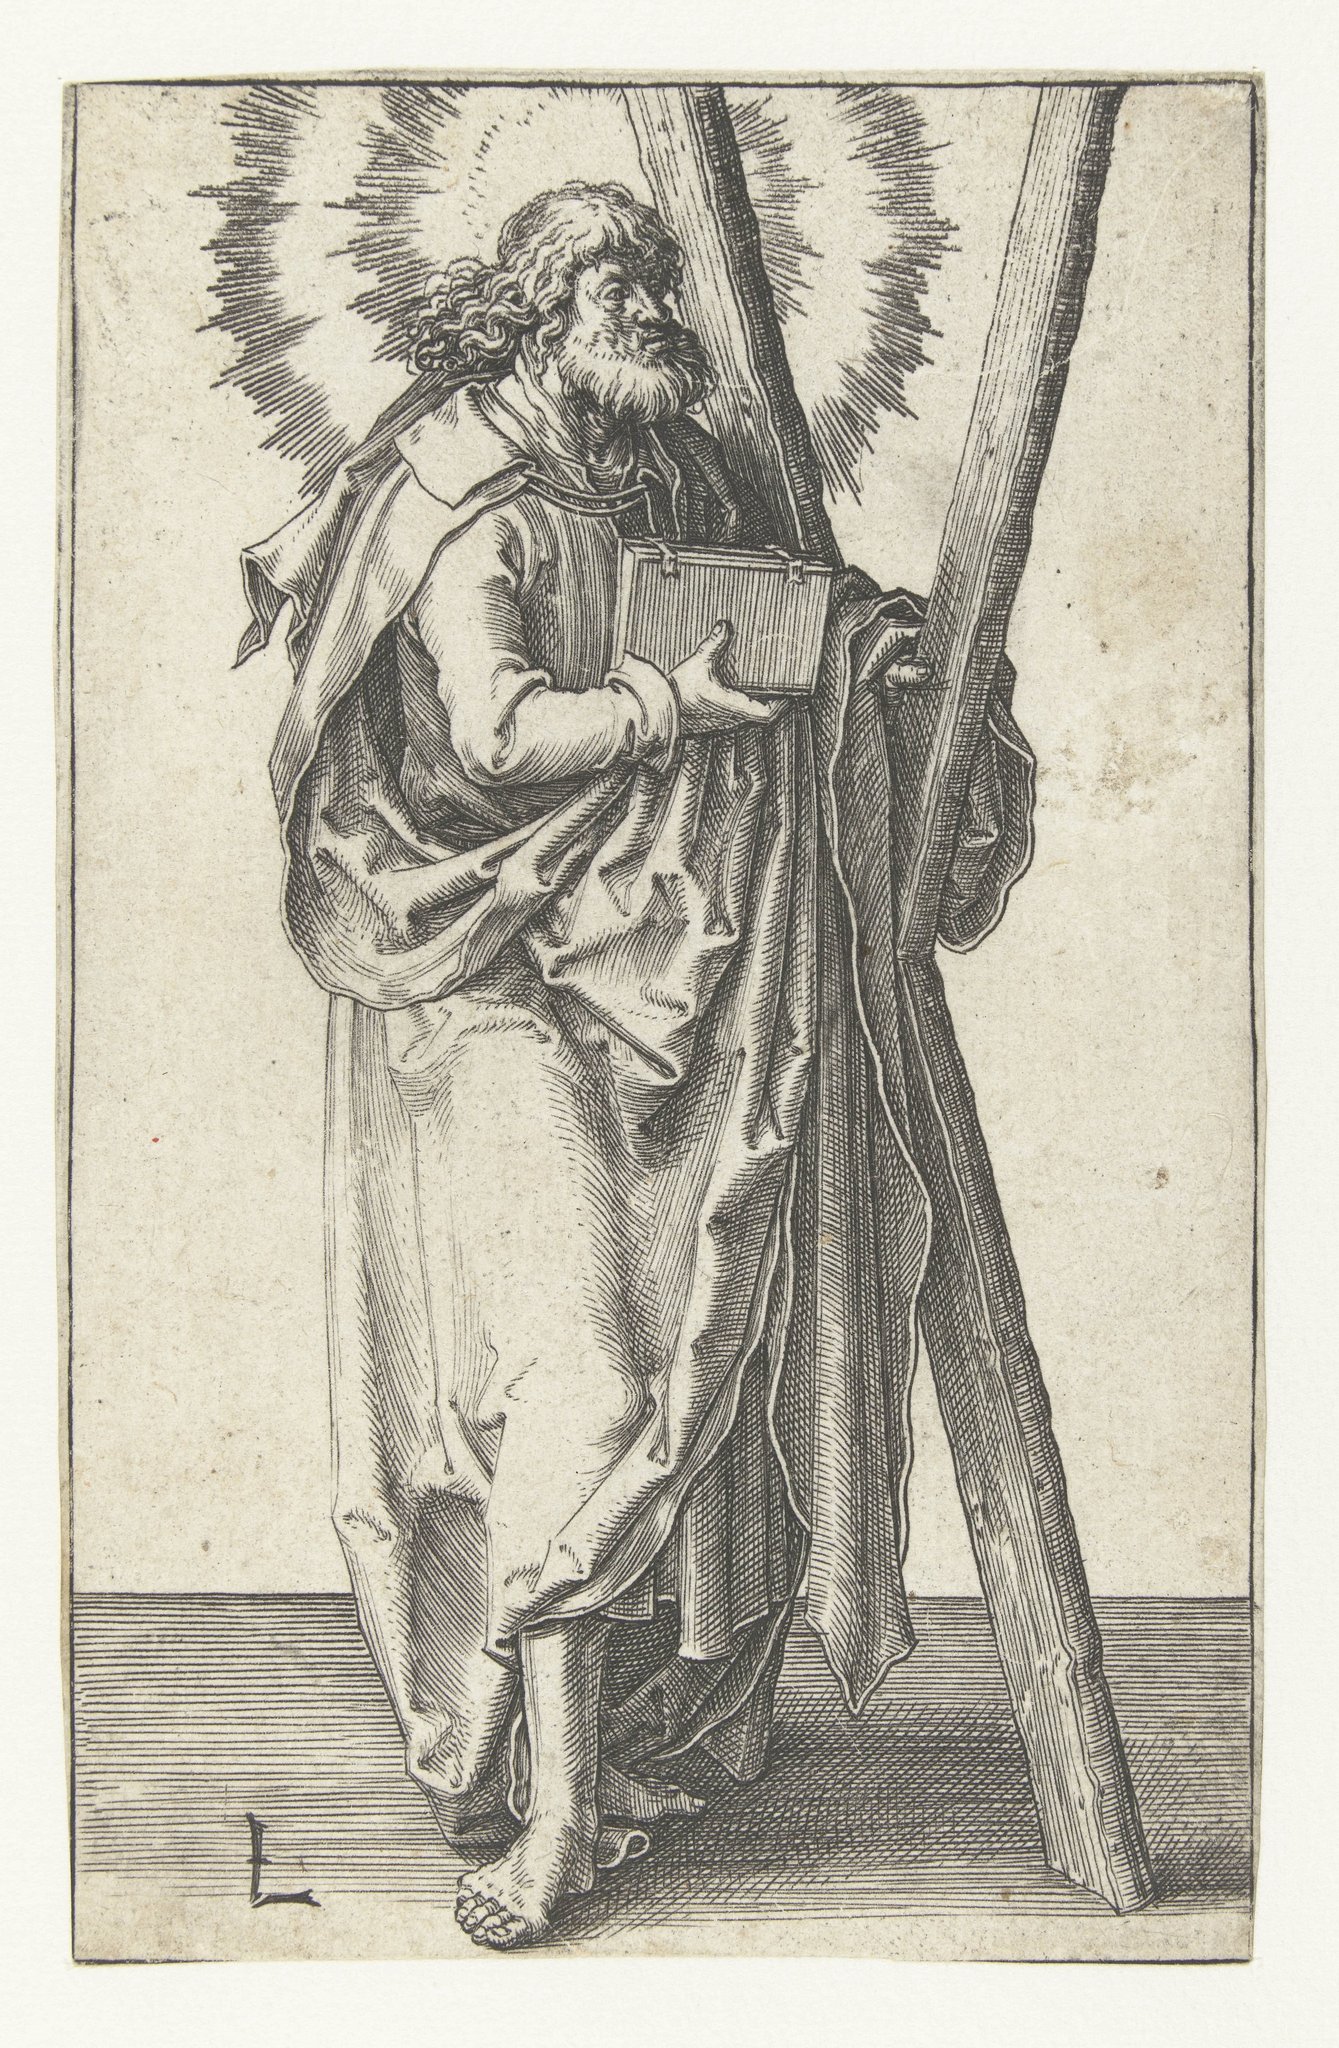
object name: print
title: De apostel Andreas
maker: lucas van leyden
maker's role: draughtsman, painter, print maker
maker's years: 1494-1533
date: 1508-1512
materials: paper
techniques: engraving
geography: low countries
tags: the apostle andrew; possible attributes: book, x-shaped cross, fish, fishing-net, rope, scroll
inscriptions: collector's mark: Lugt 2228a